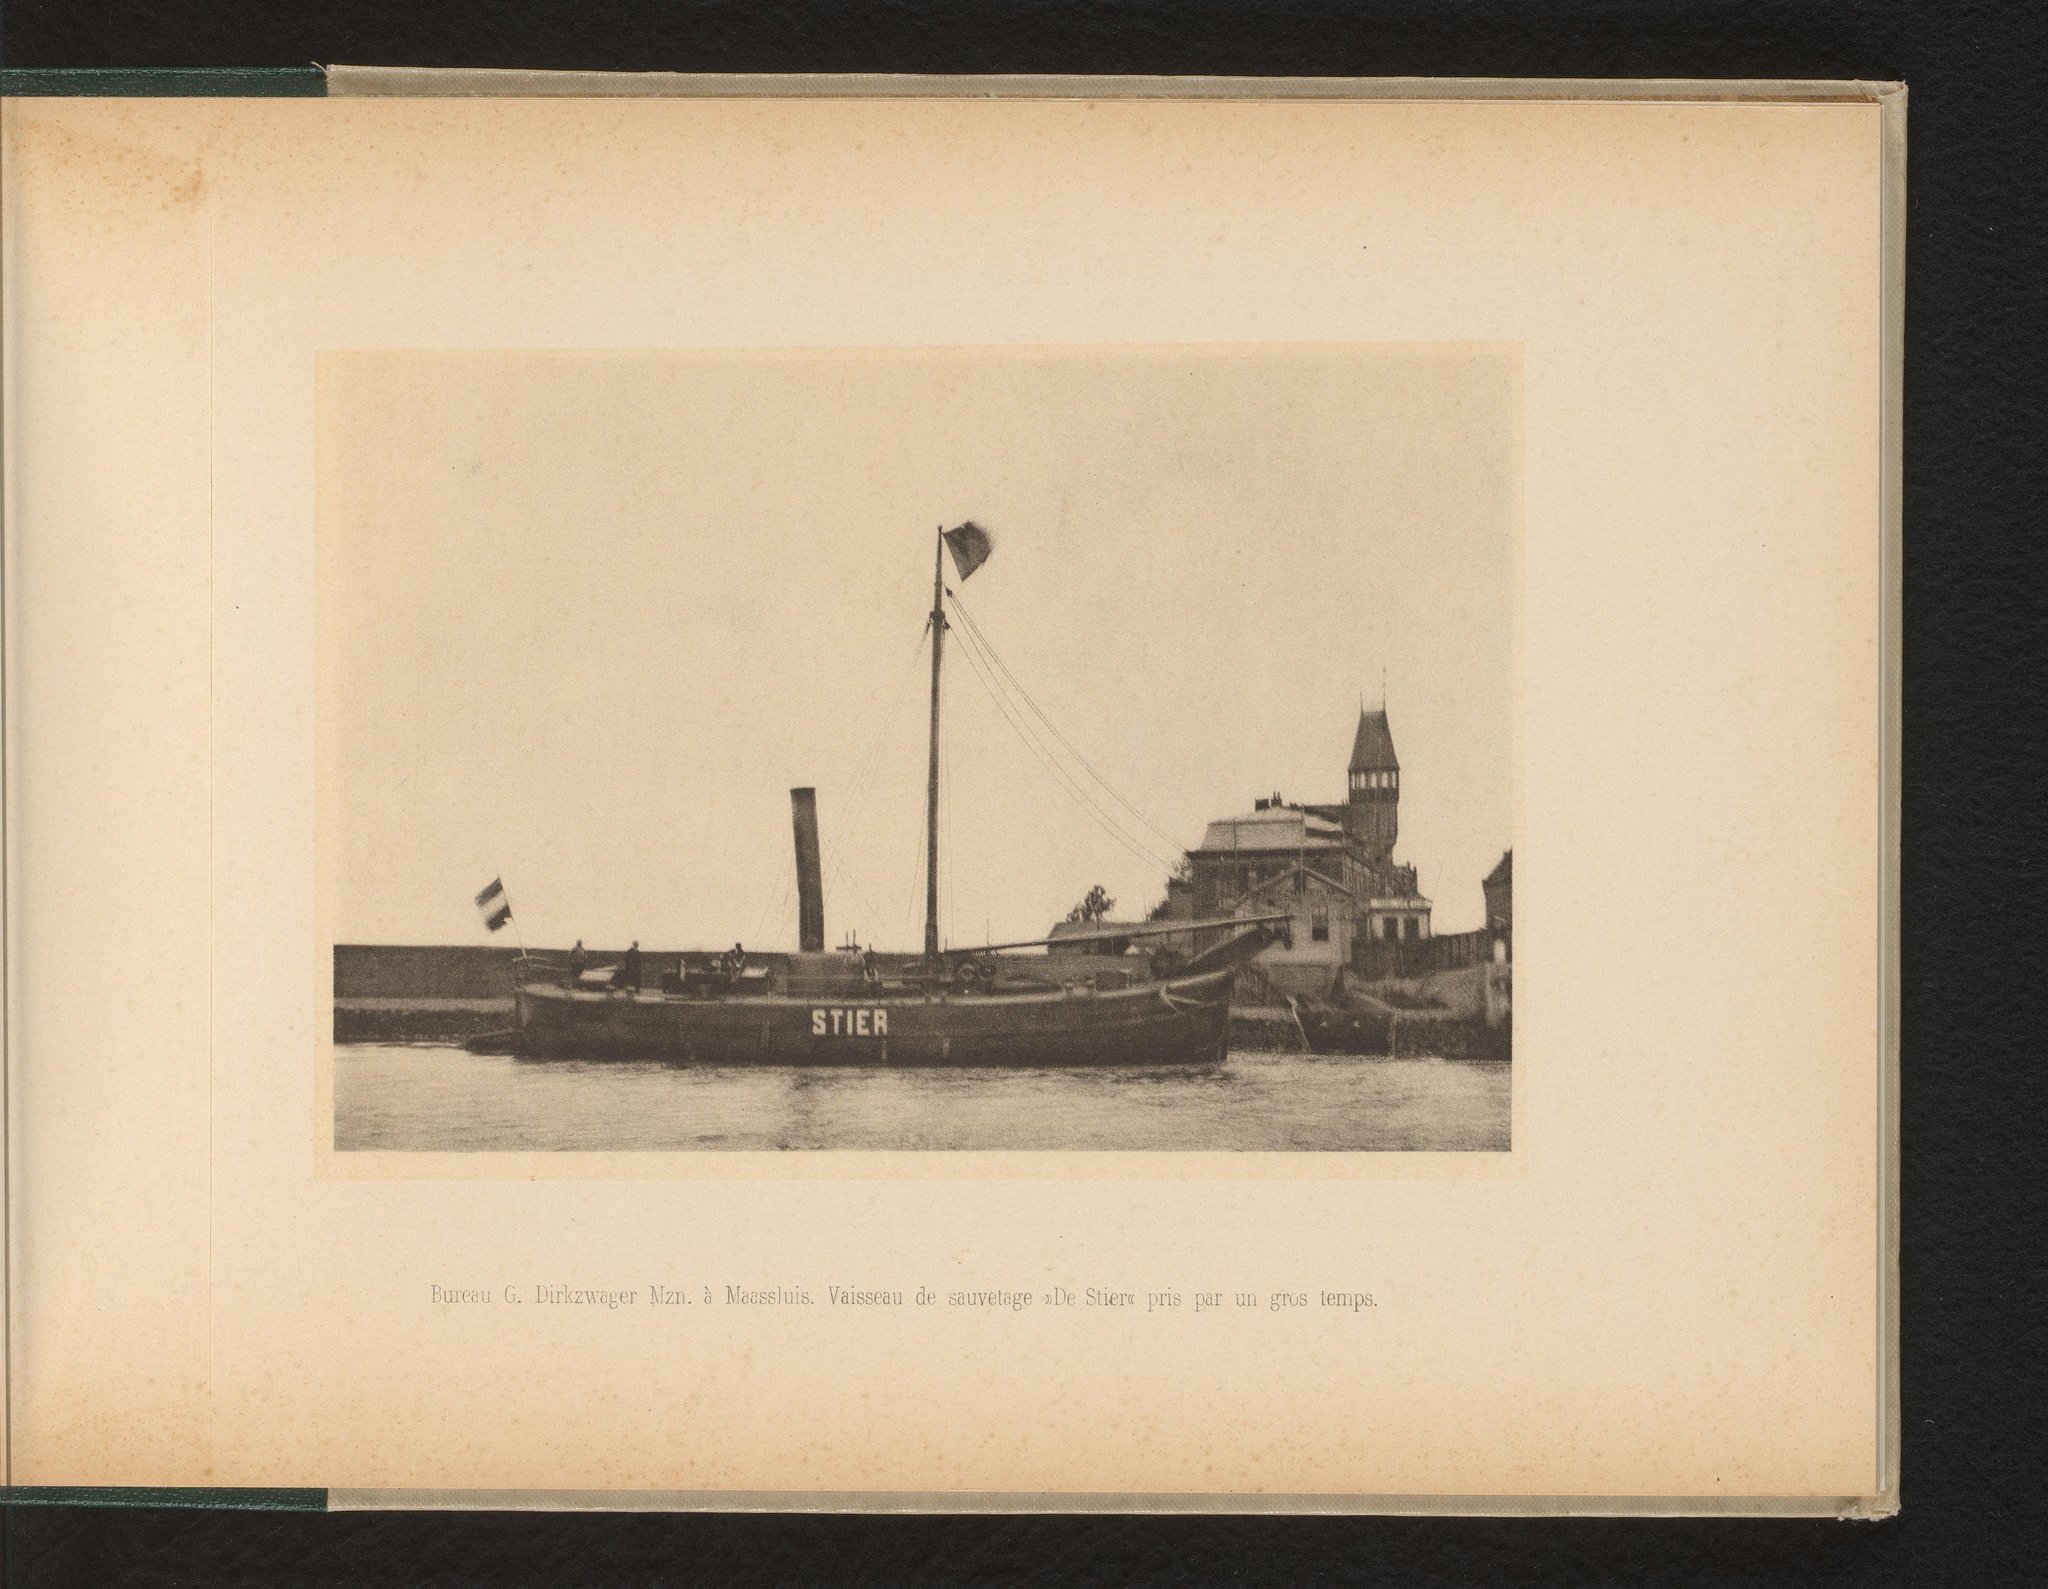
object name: page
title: Bureau G. Dirkzwager Mzn. à Maassluis. Vaisseau de sauvetage "De Stier"pris par un gros temps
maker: Anonymous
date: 1902-1907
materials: paper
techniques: photograph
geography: rotterdam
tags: harbour, rotterdam